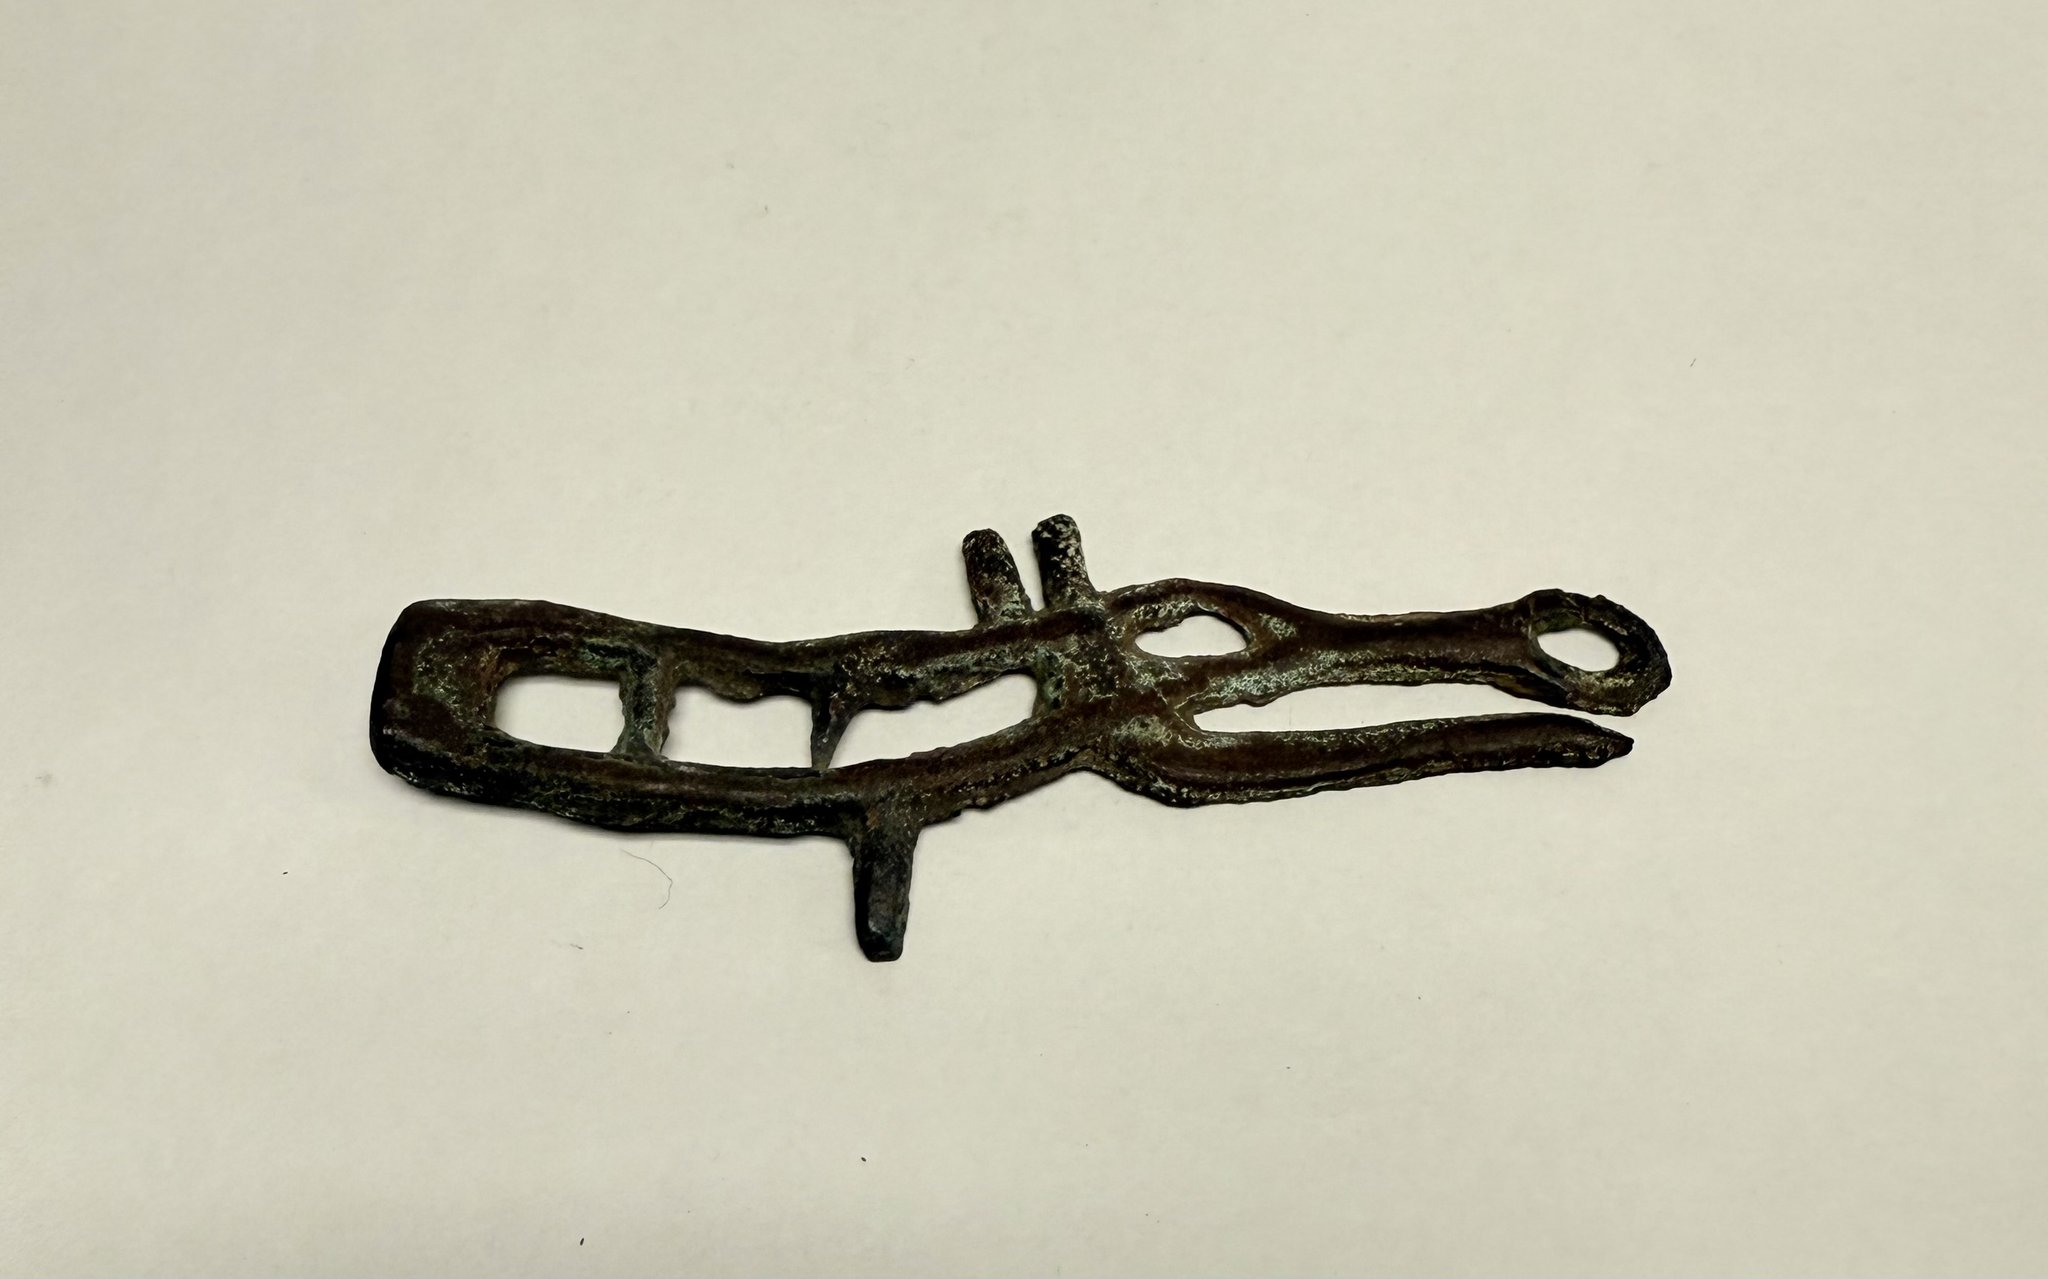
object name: plaque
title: Horse's Head Plaque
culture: western siberian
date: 1-100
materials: bronze